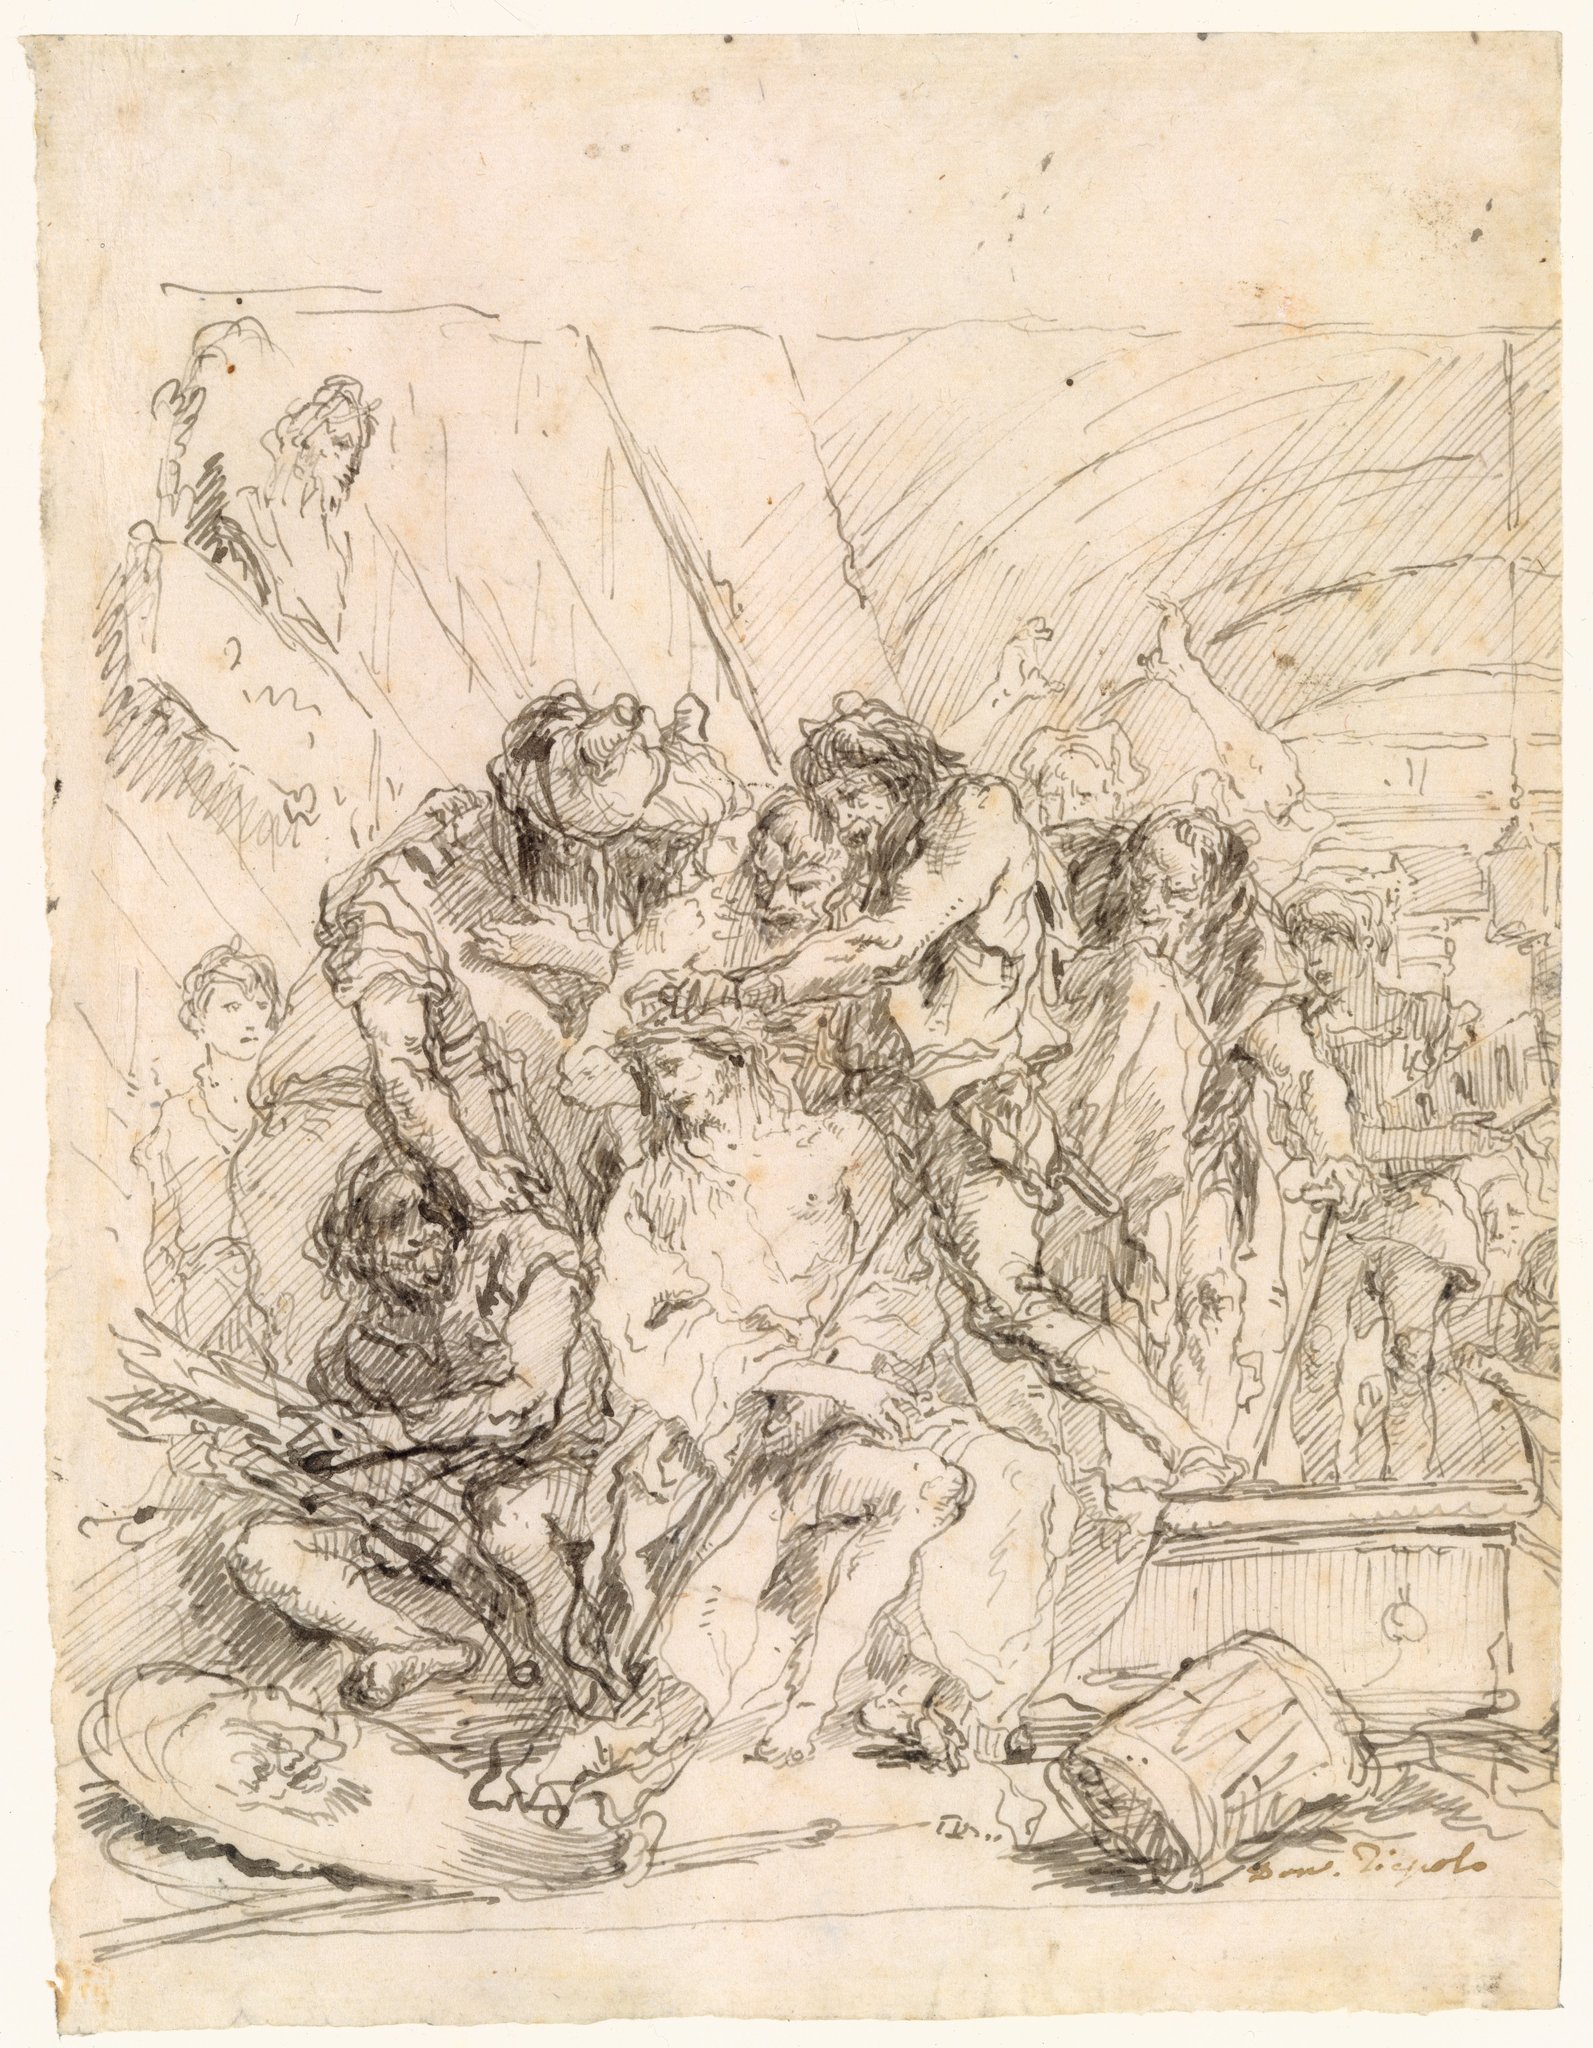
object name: drawing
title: Christ Crowned with Thorns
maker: giovanni domenico tiepolo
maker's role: artist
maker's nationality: italian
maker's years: 1727-1804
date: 1748-1772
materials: ink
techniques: pen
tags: men,christ